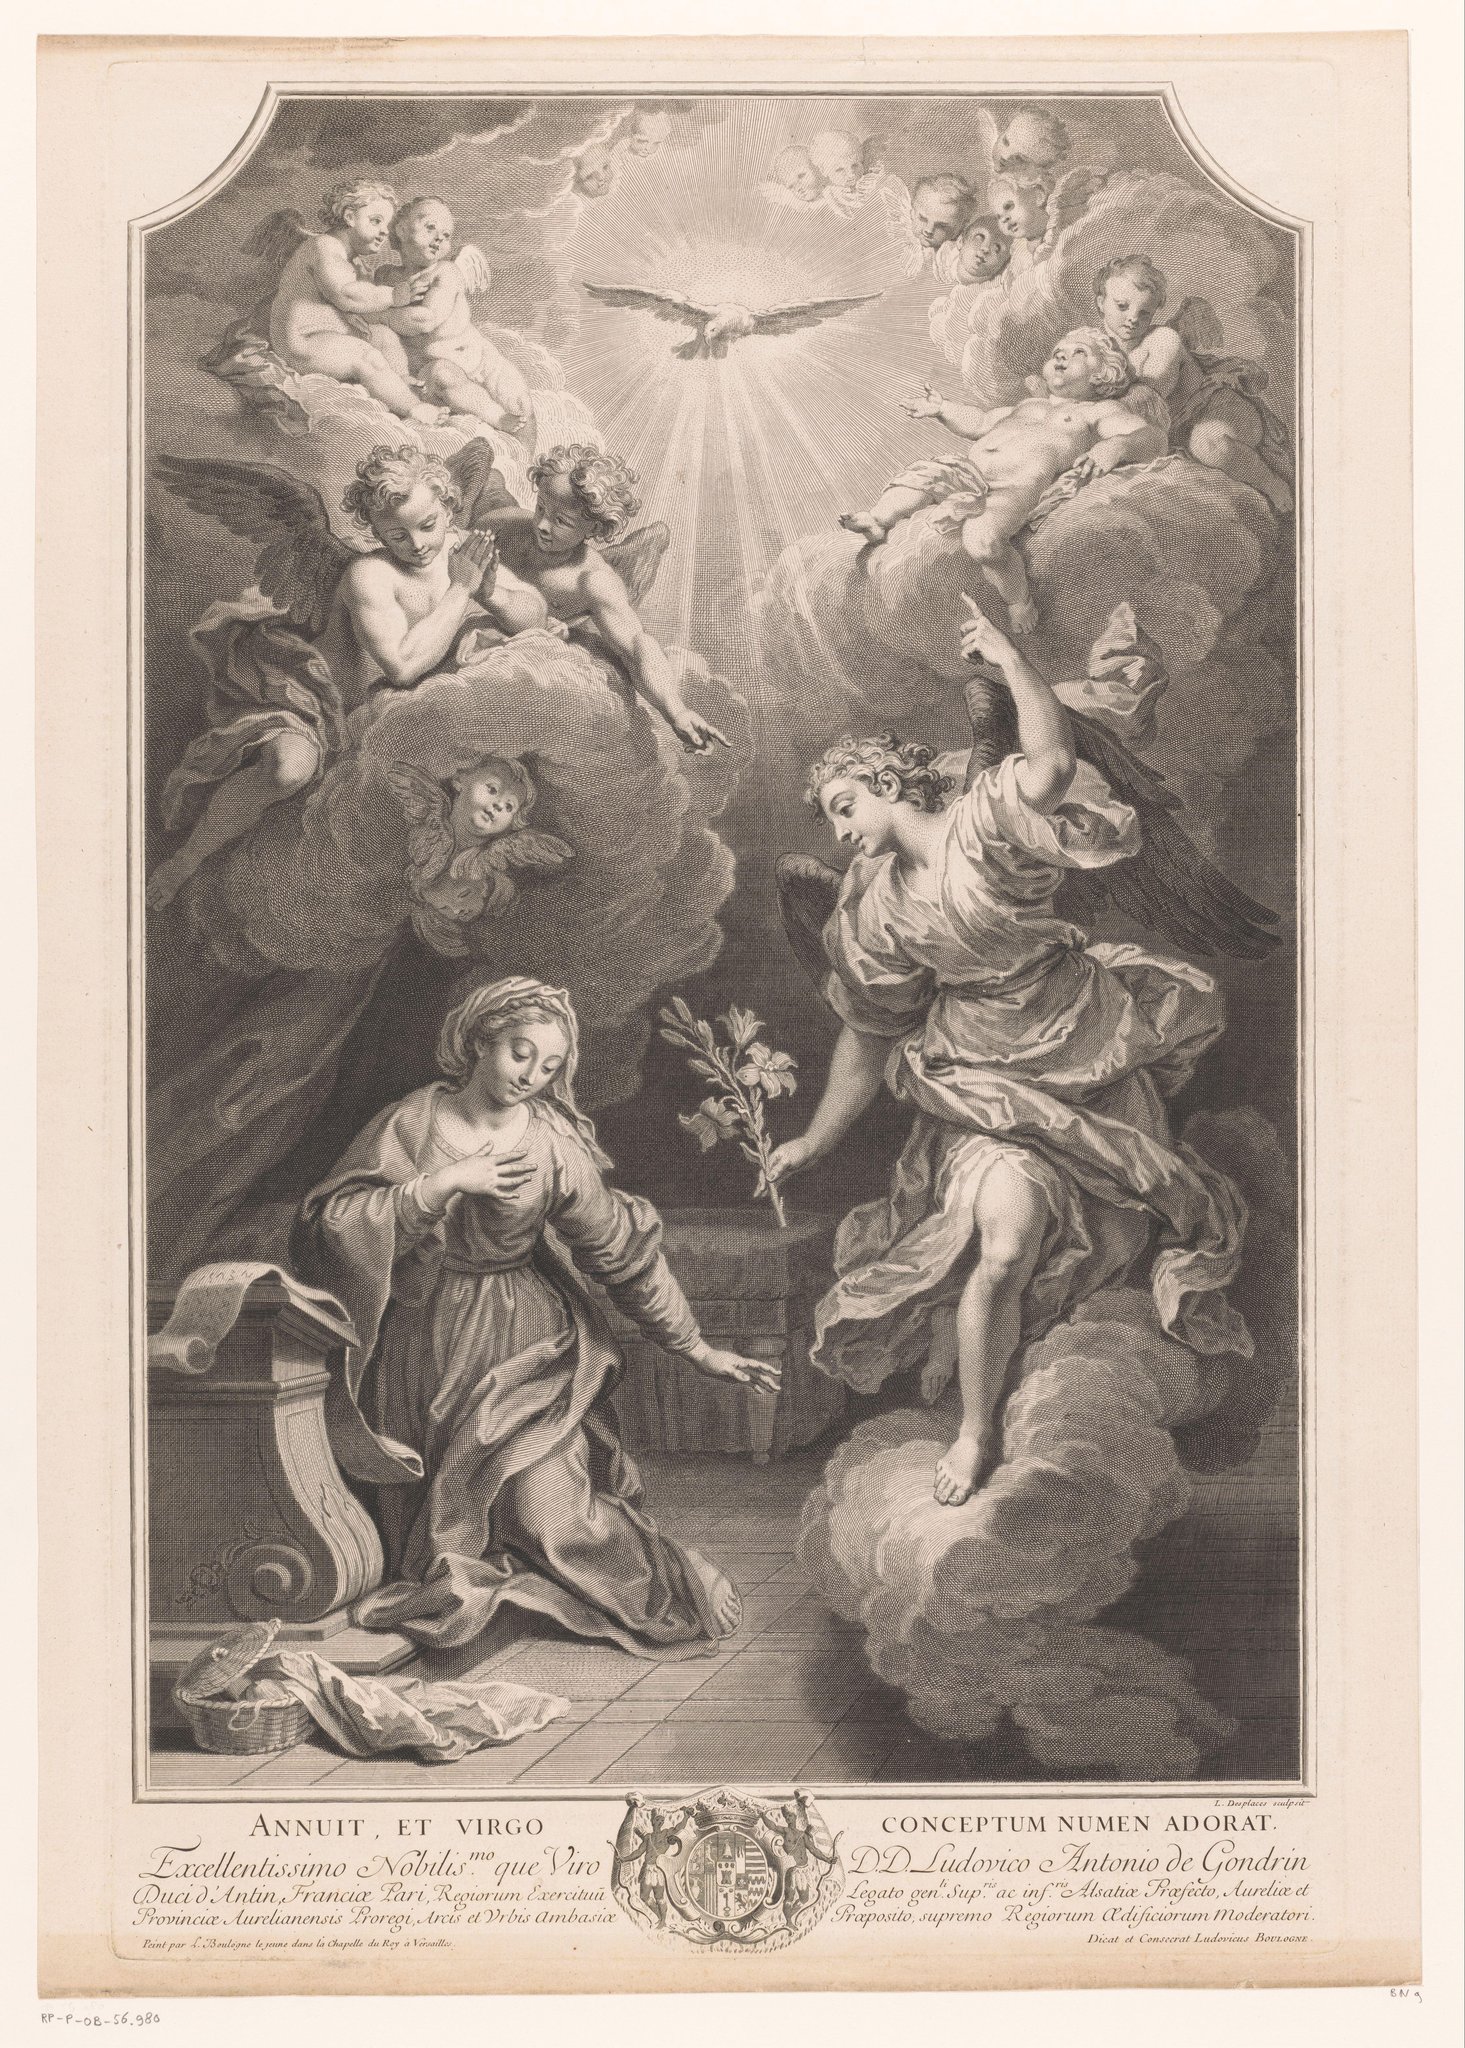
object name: print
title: Annunciatie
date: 1710-1739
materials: paper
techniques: engraving, etching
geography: versailles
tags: the annunciation: mary, usually reading, is visited by the angel (sometimes a woman overhears the conversation)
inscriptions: collector's mark: Lugt 240, number: ‘f 550-’